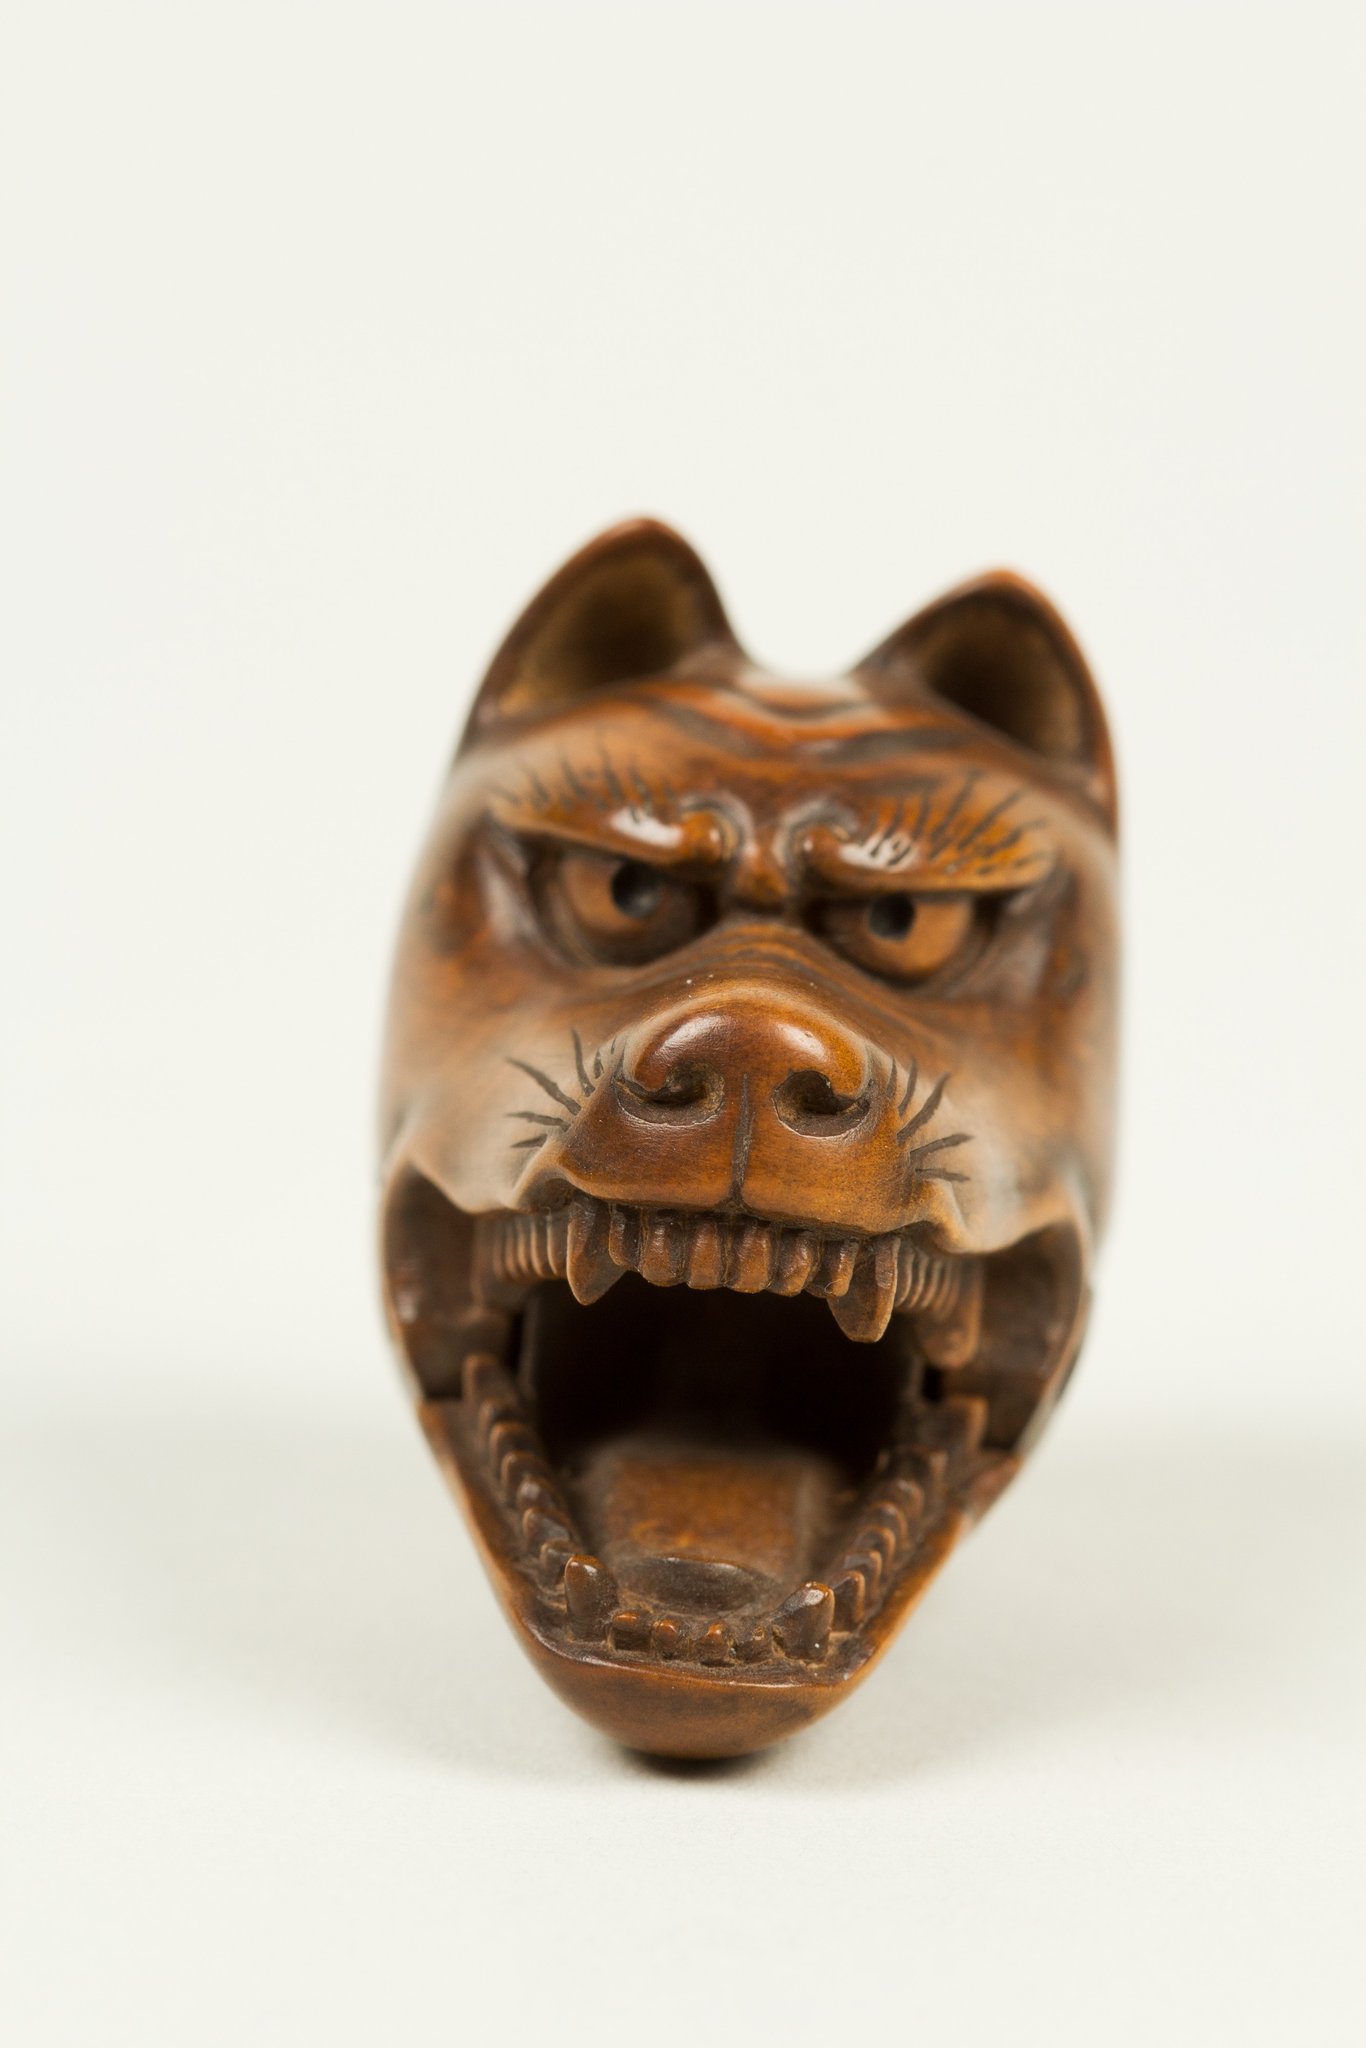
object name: netsuke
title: Netsuke of Kyōgen Mask; Kitsune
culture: japanese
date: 1801-1900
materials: wood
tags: animals,masks